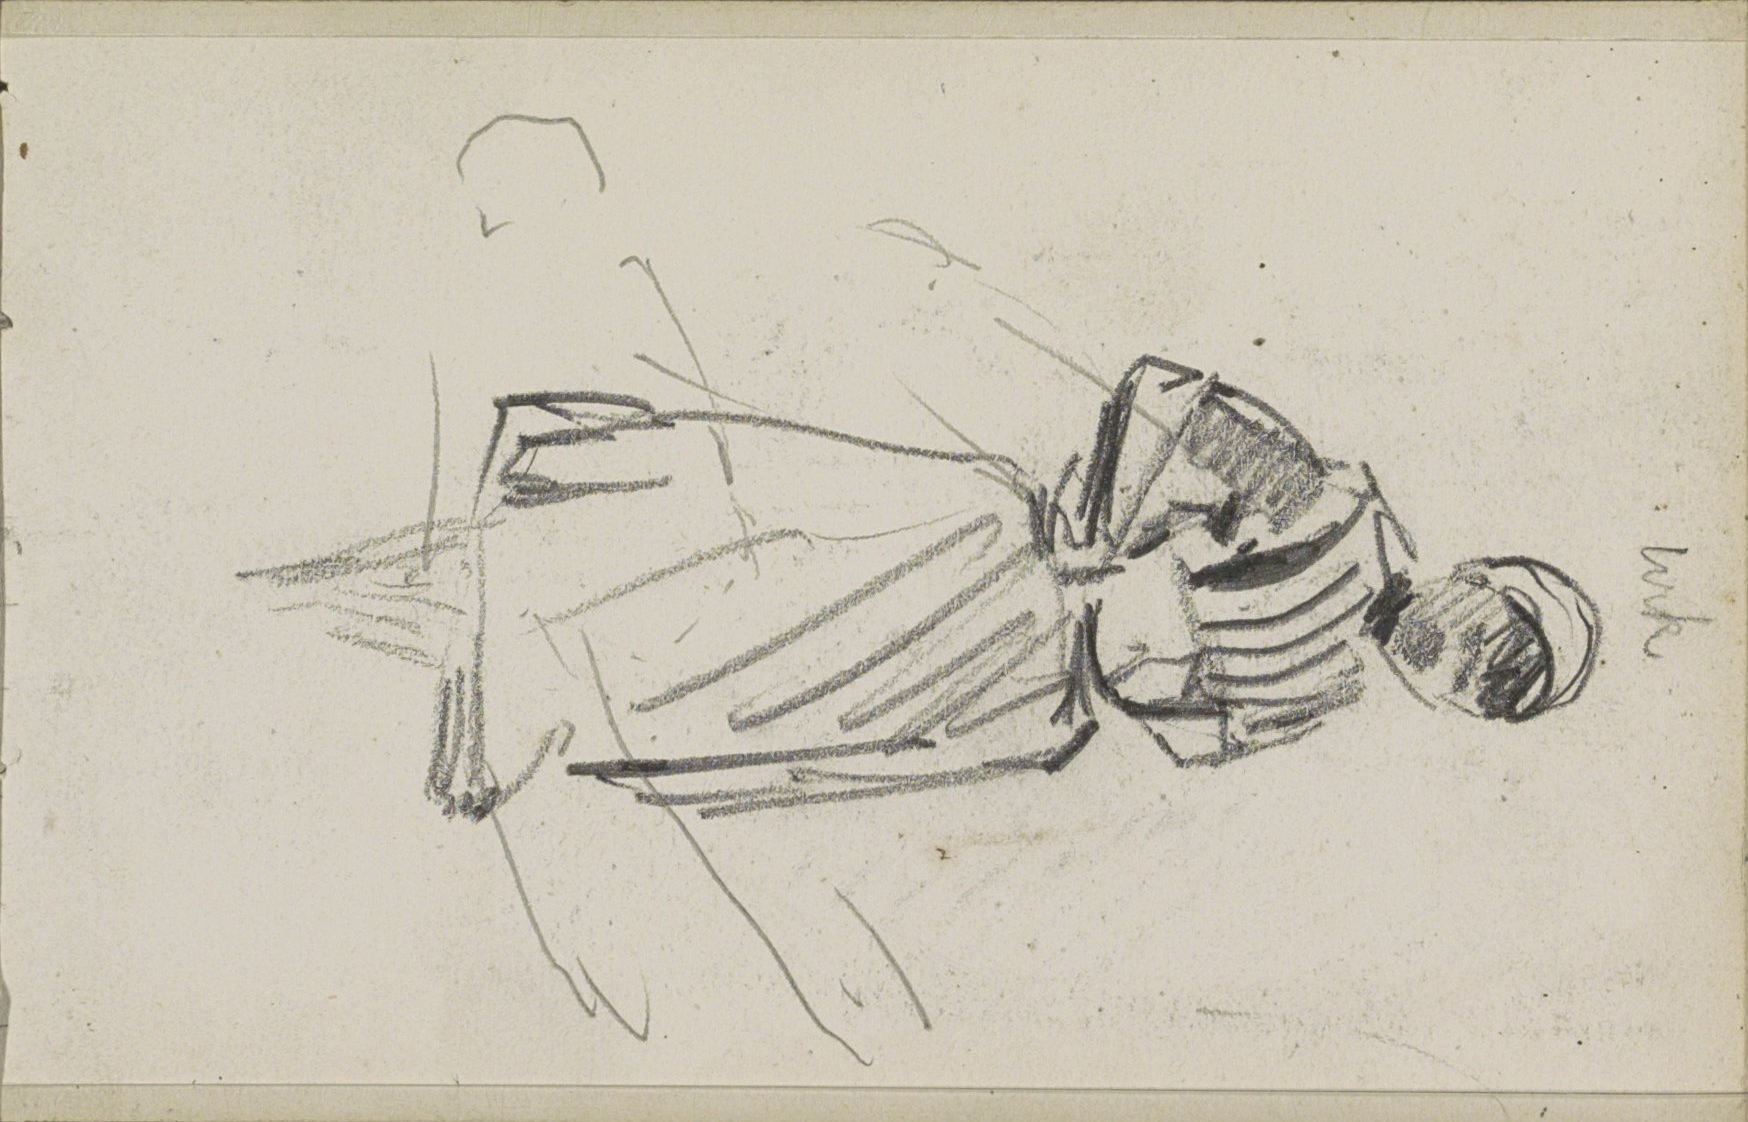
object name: sketchbook leaf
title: Jonge vrouw in Urker klederdracht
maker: george clausen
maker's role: draughtsman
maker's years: 1852-1912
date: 1875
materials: paper, pencil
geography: urk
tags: folk costume, regional costume (+ women's clothes)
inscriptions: annotation: ‘Urk’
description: Blad 20 recto uit een schetsboek met 38 bladen.